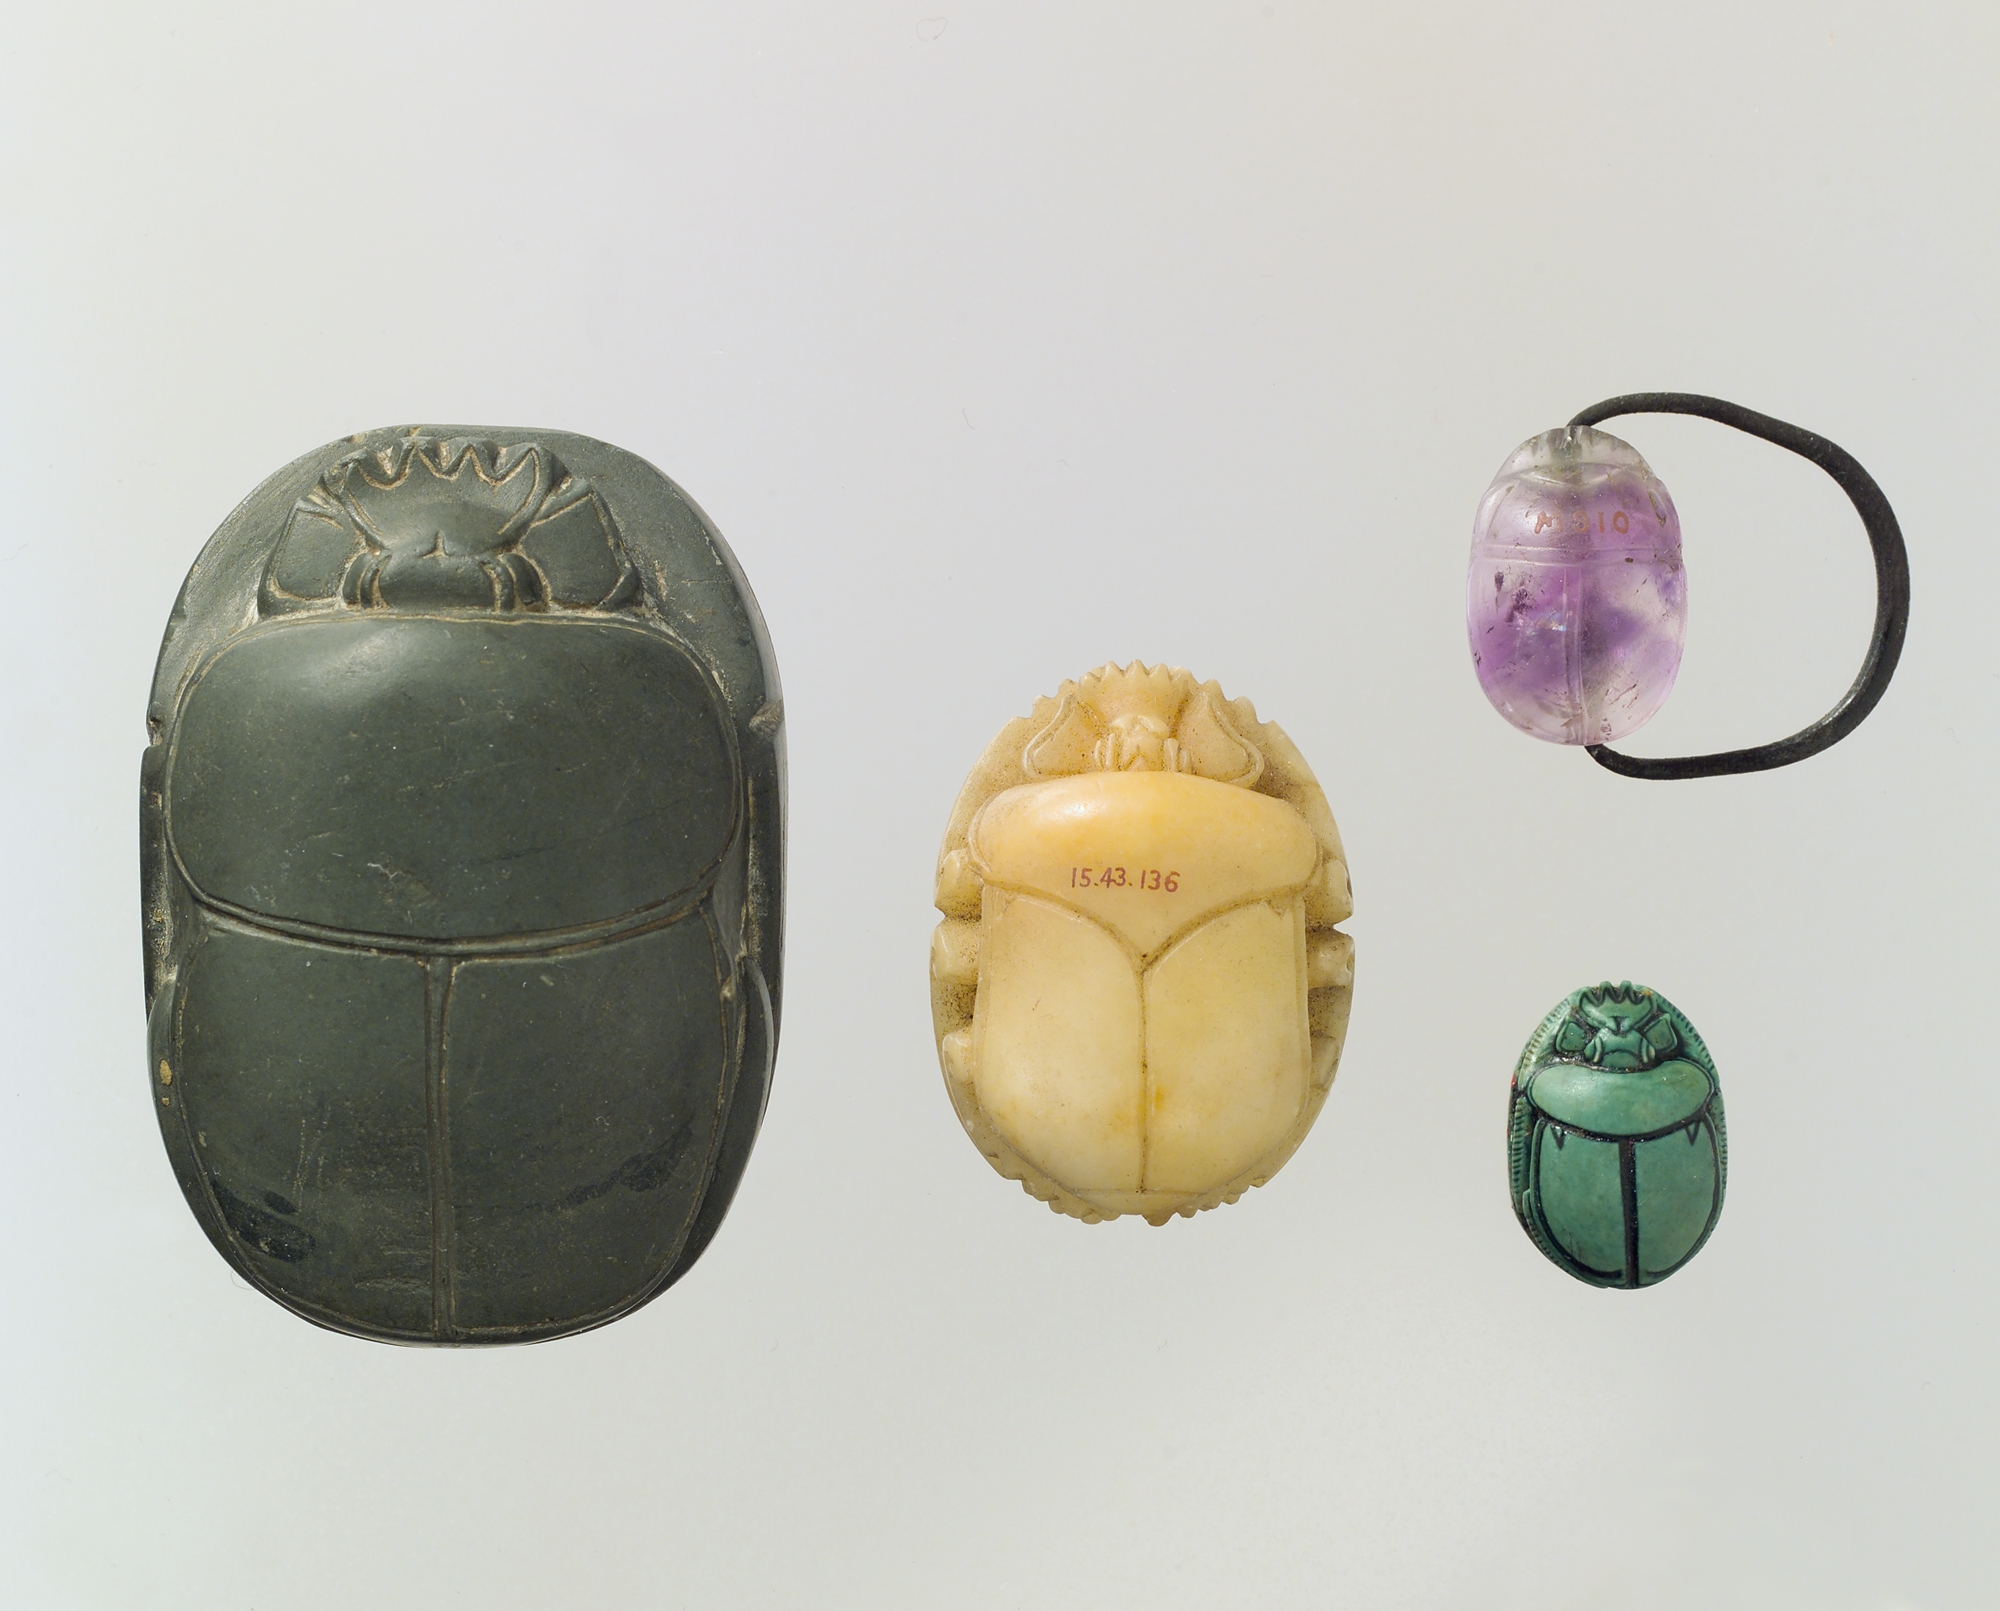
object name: ring with scarab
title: Scarabs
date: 1981-1802 BCE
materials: gemstone, copper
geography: egypt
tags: scarabs